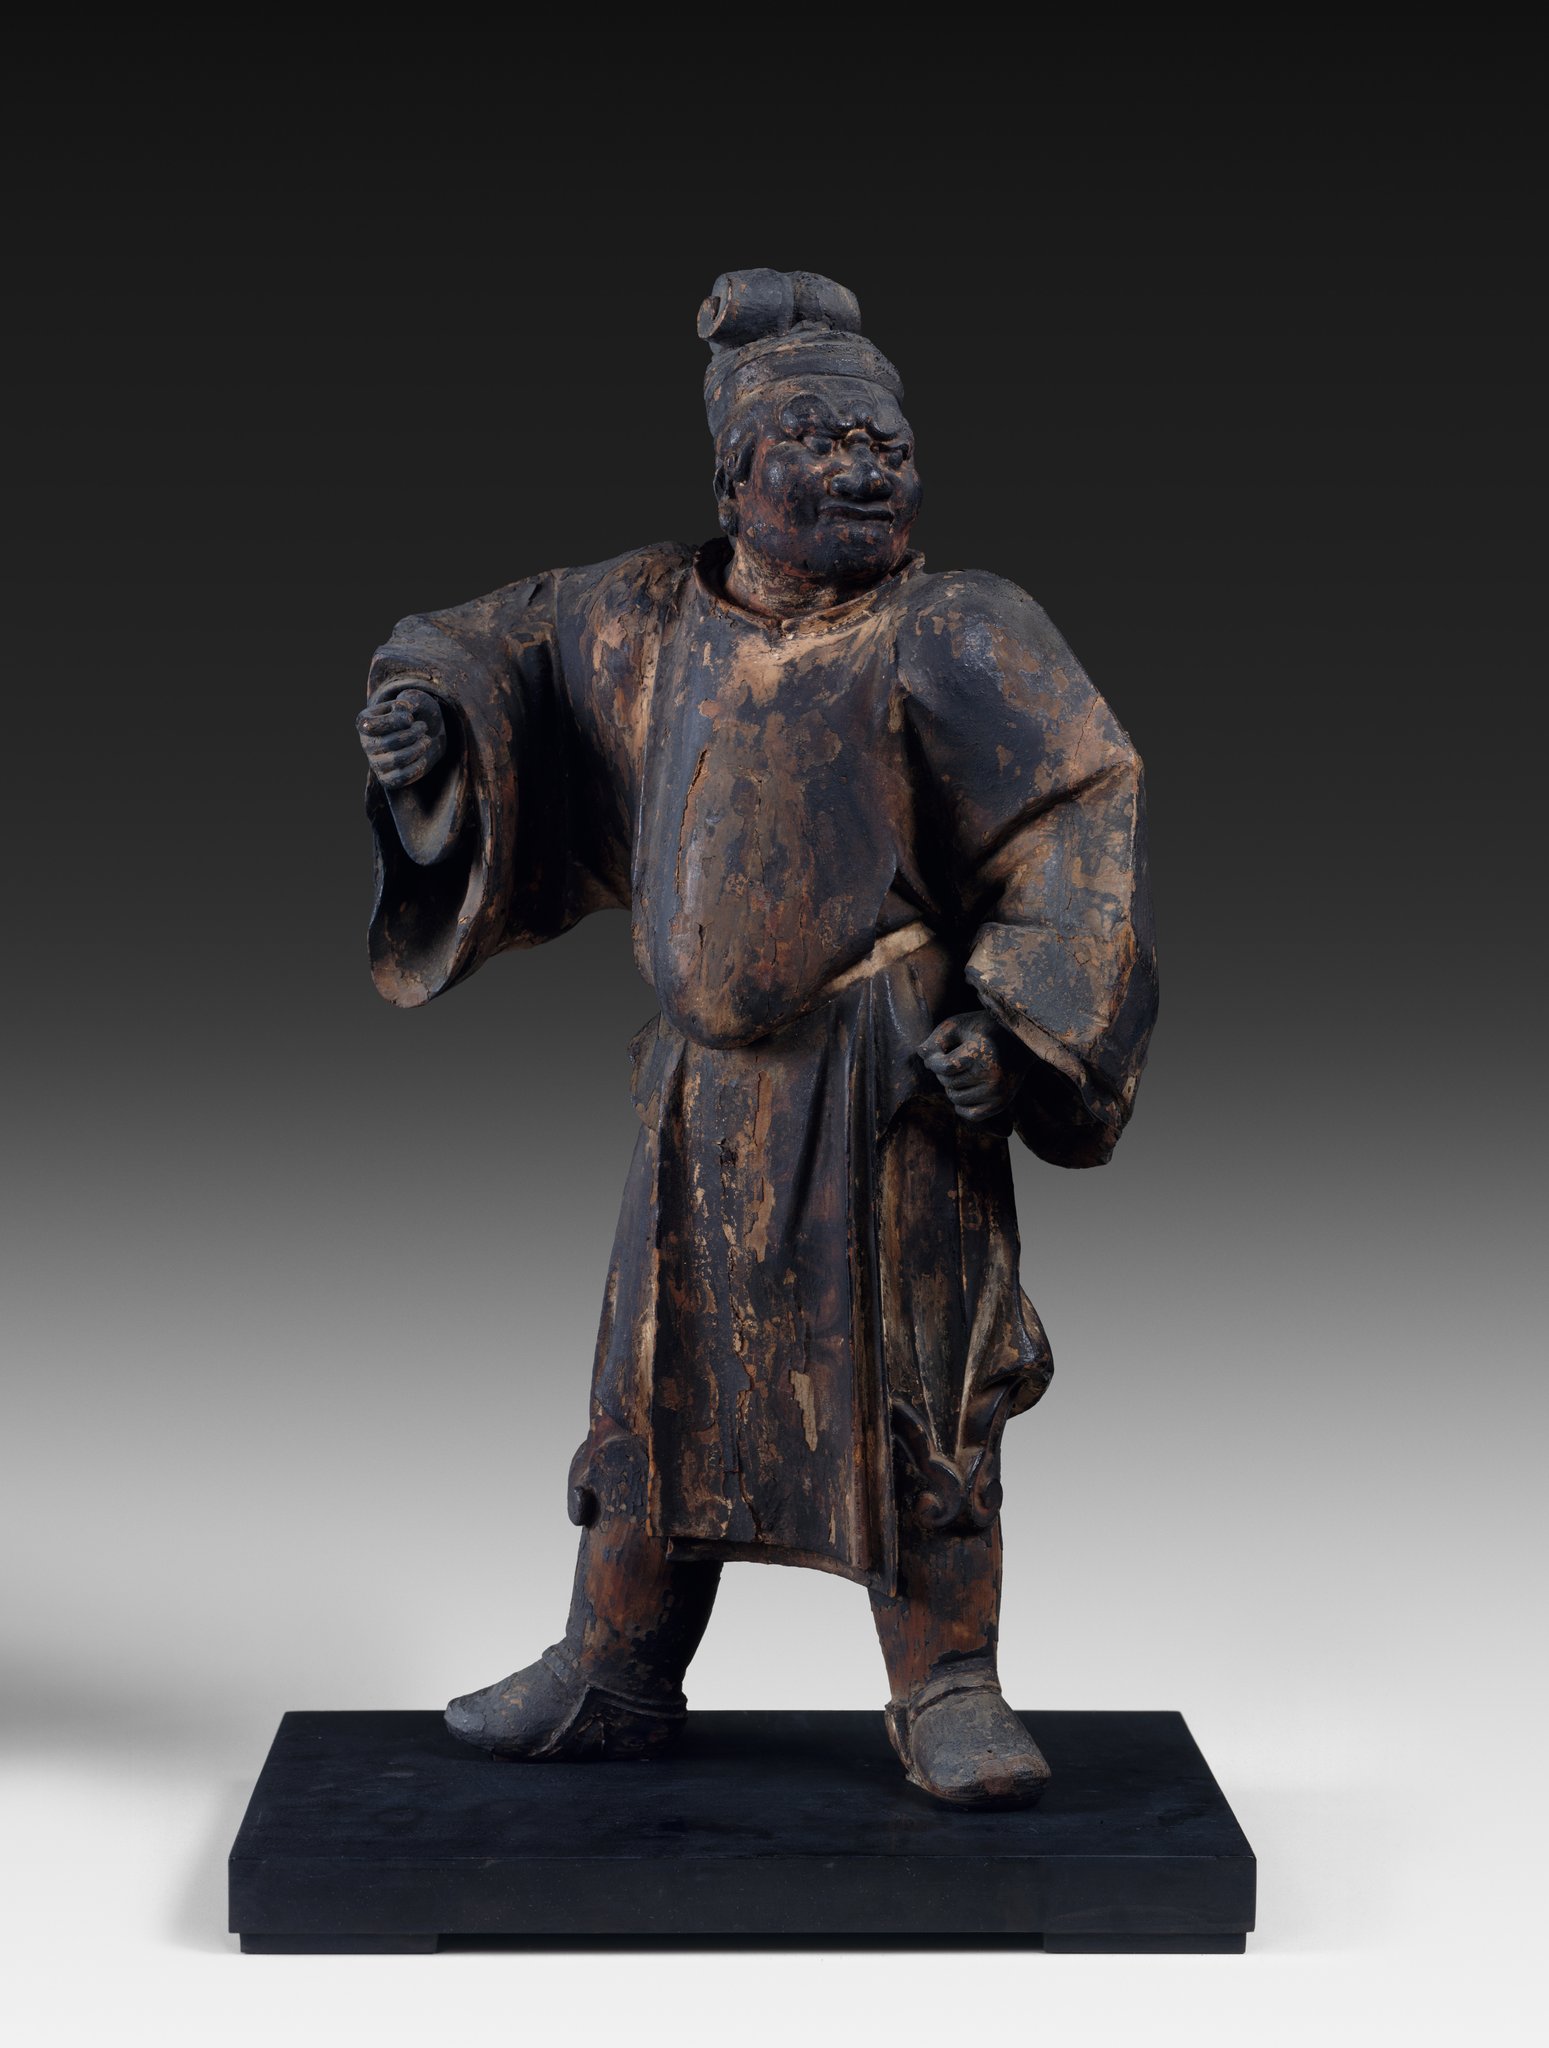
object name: figure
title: Gushōjin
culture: japanese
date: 1201-1300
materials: lacquer, pigment, wood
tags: men